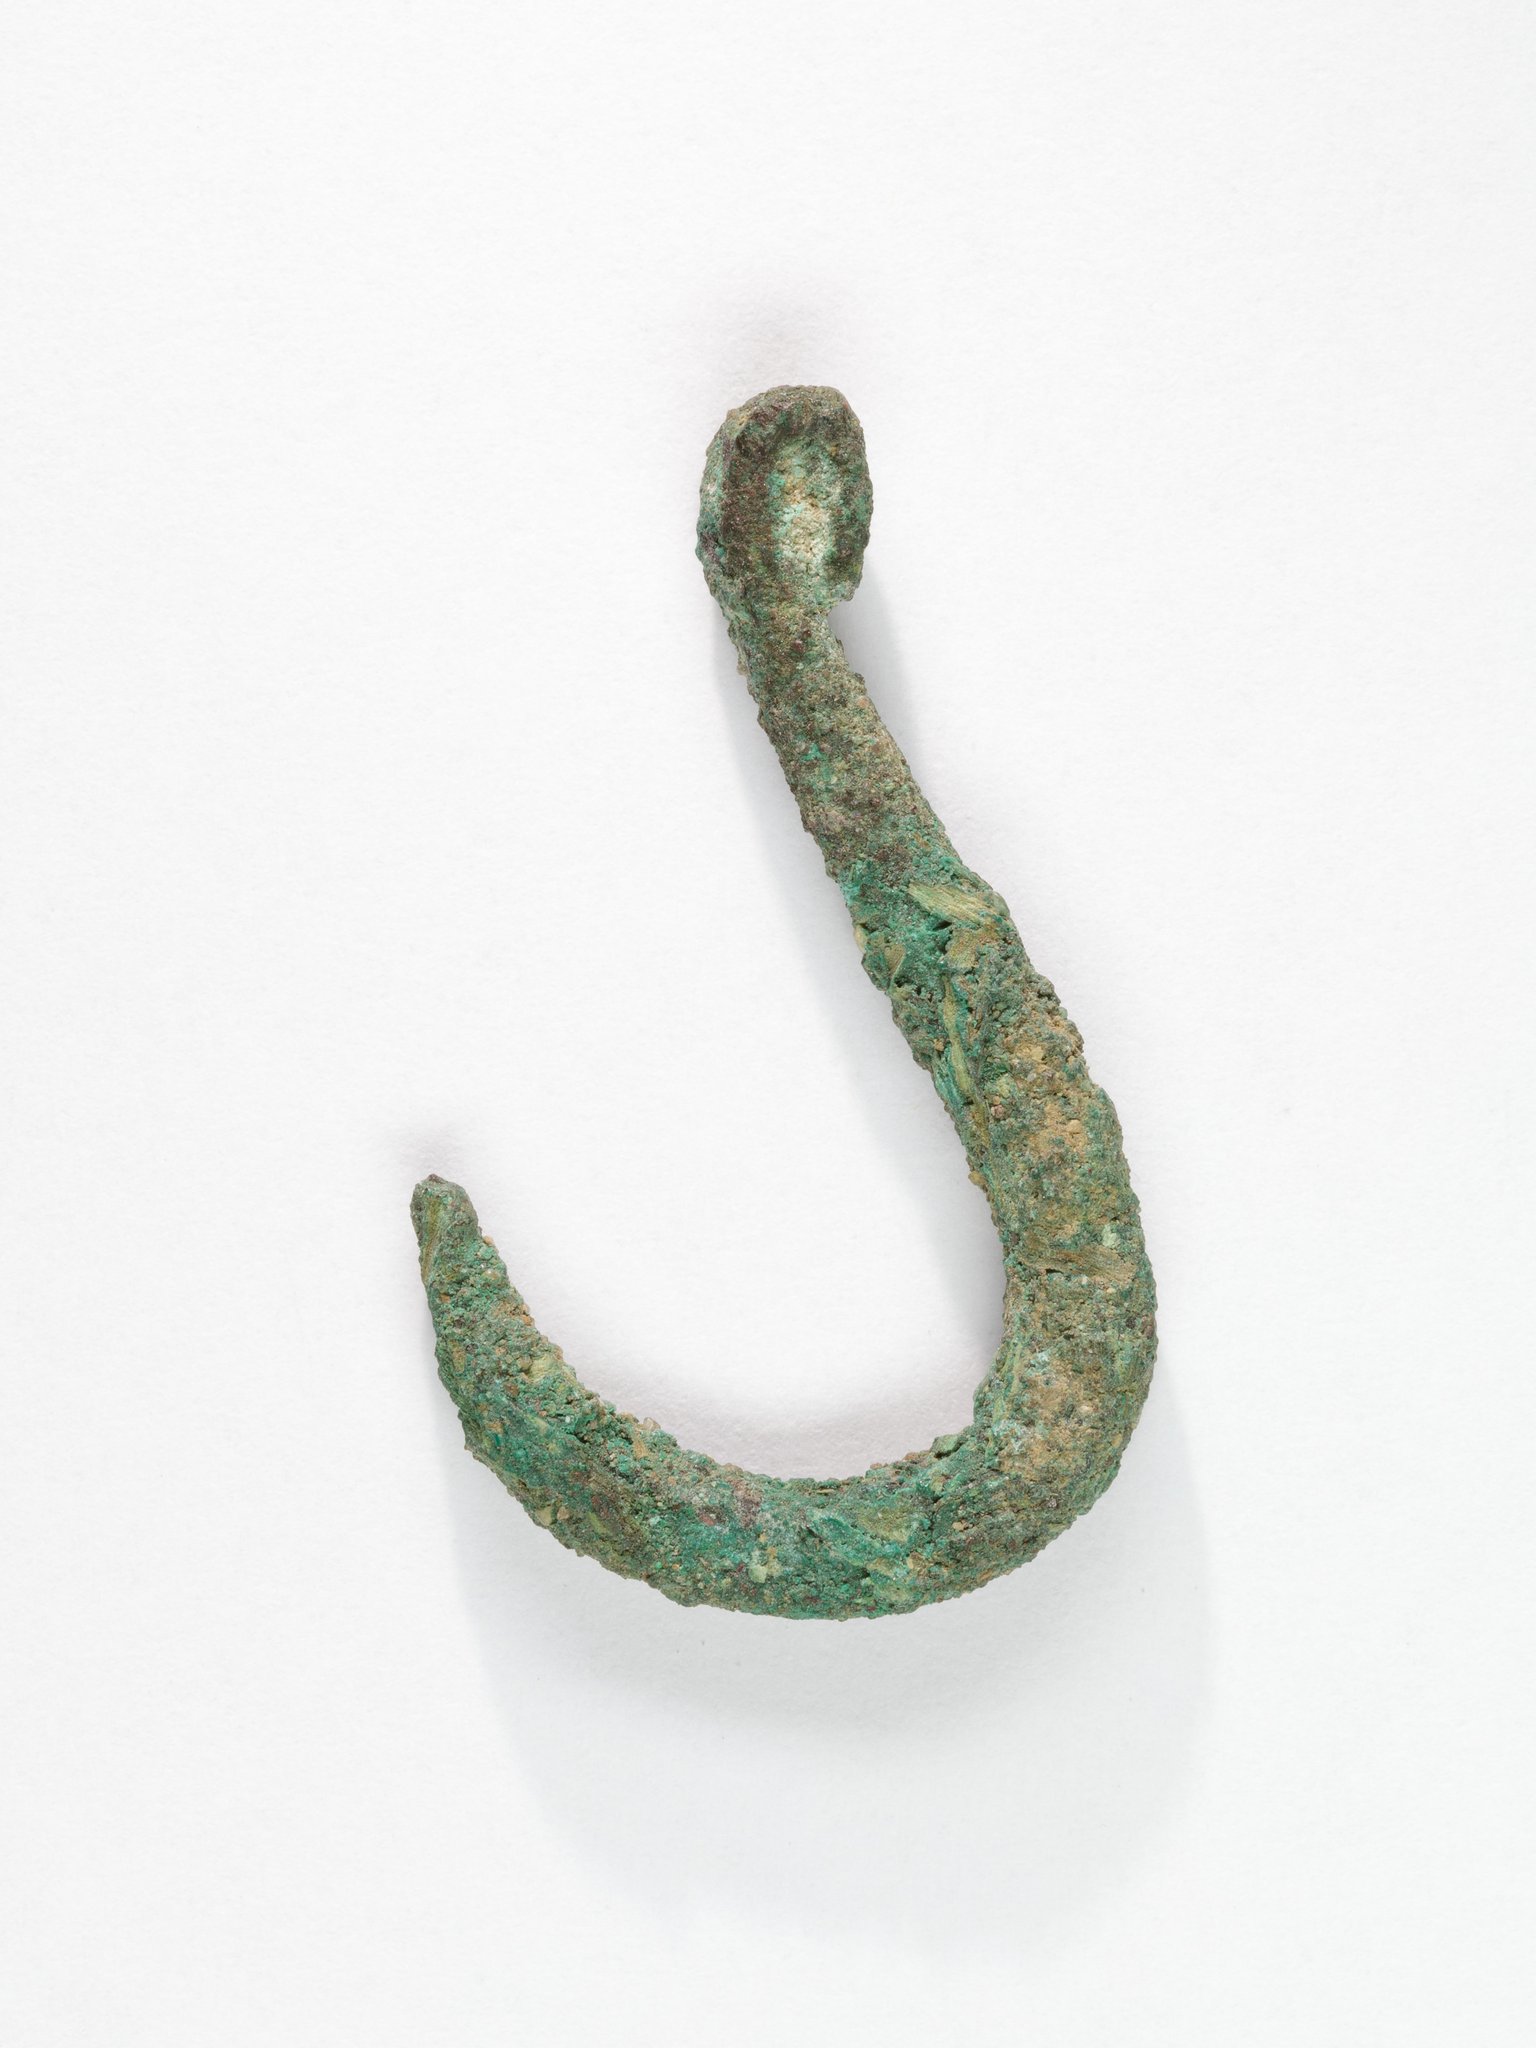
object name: fish hook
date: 1295-1070 BCE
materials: bronze, copper alloy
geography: northern upper egypt